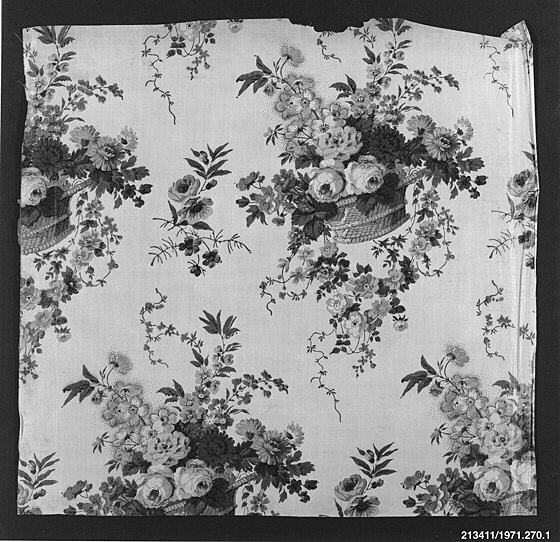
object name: sample book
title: Textile Sample Book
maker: frier riber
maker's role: artist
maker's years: 1750-1900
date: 1845-1860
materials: cotton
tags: flowers